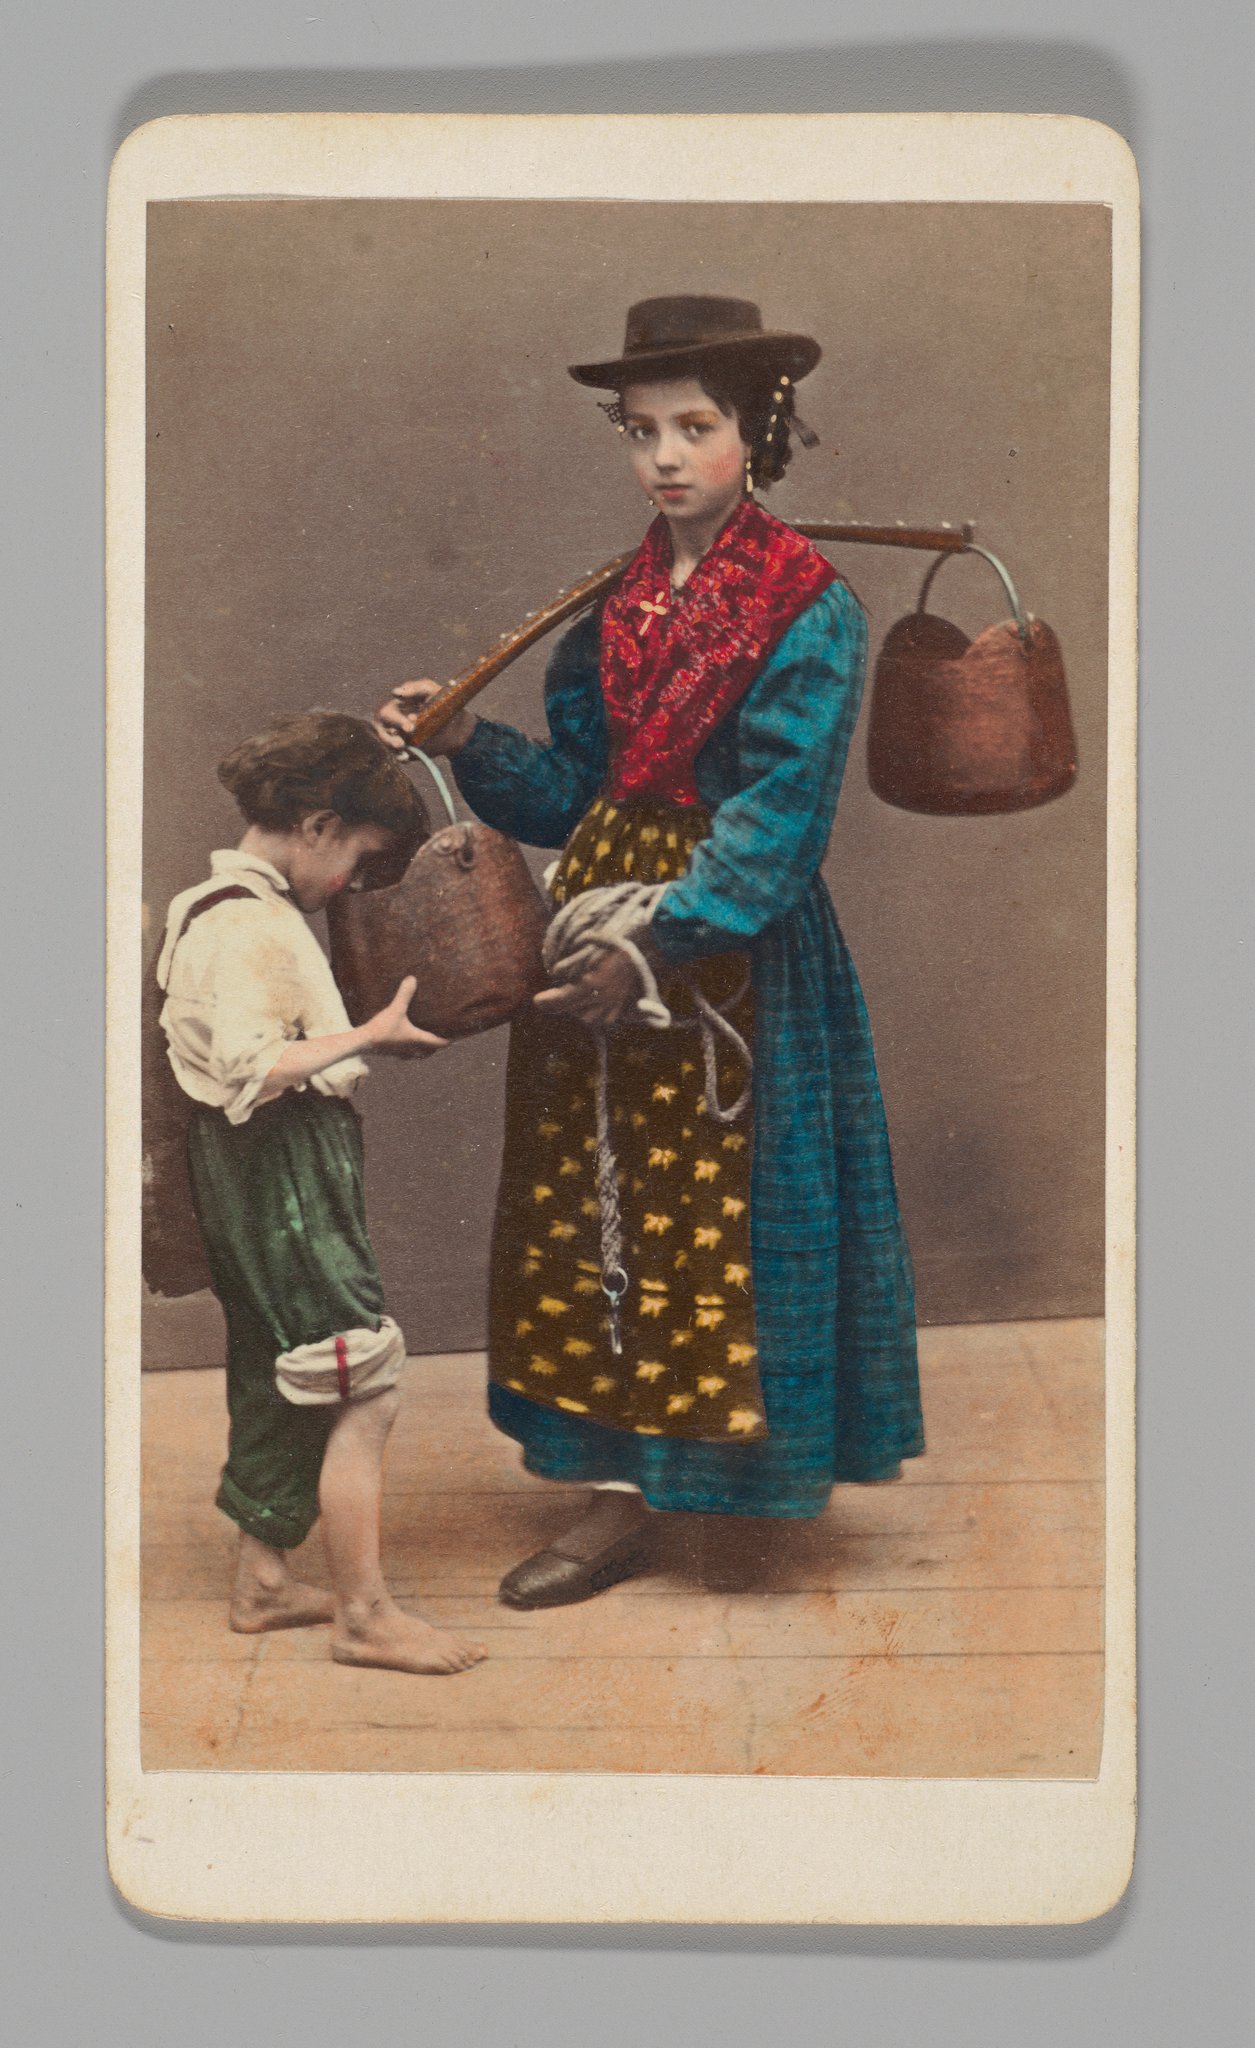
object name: carte de visite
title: [Studio Portrait: Woman Carrying Yoke with Young Boy, Venice]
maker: carlo ponti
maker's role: fotograaf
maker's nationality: italian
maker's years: 1820-1893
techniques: albumen silver print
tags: boys,portraits,women